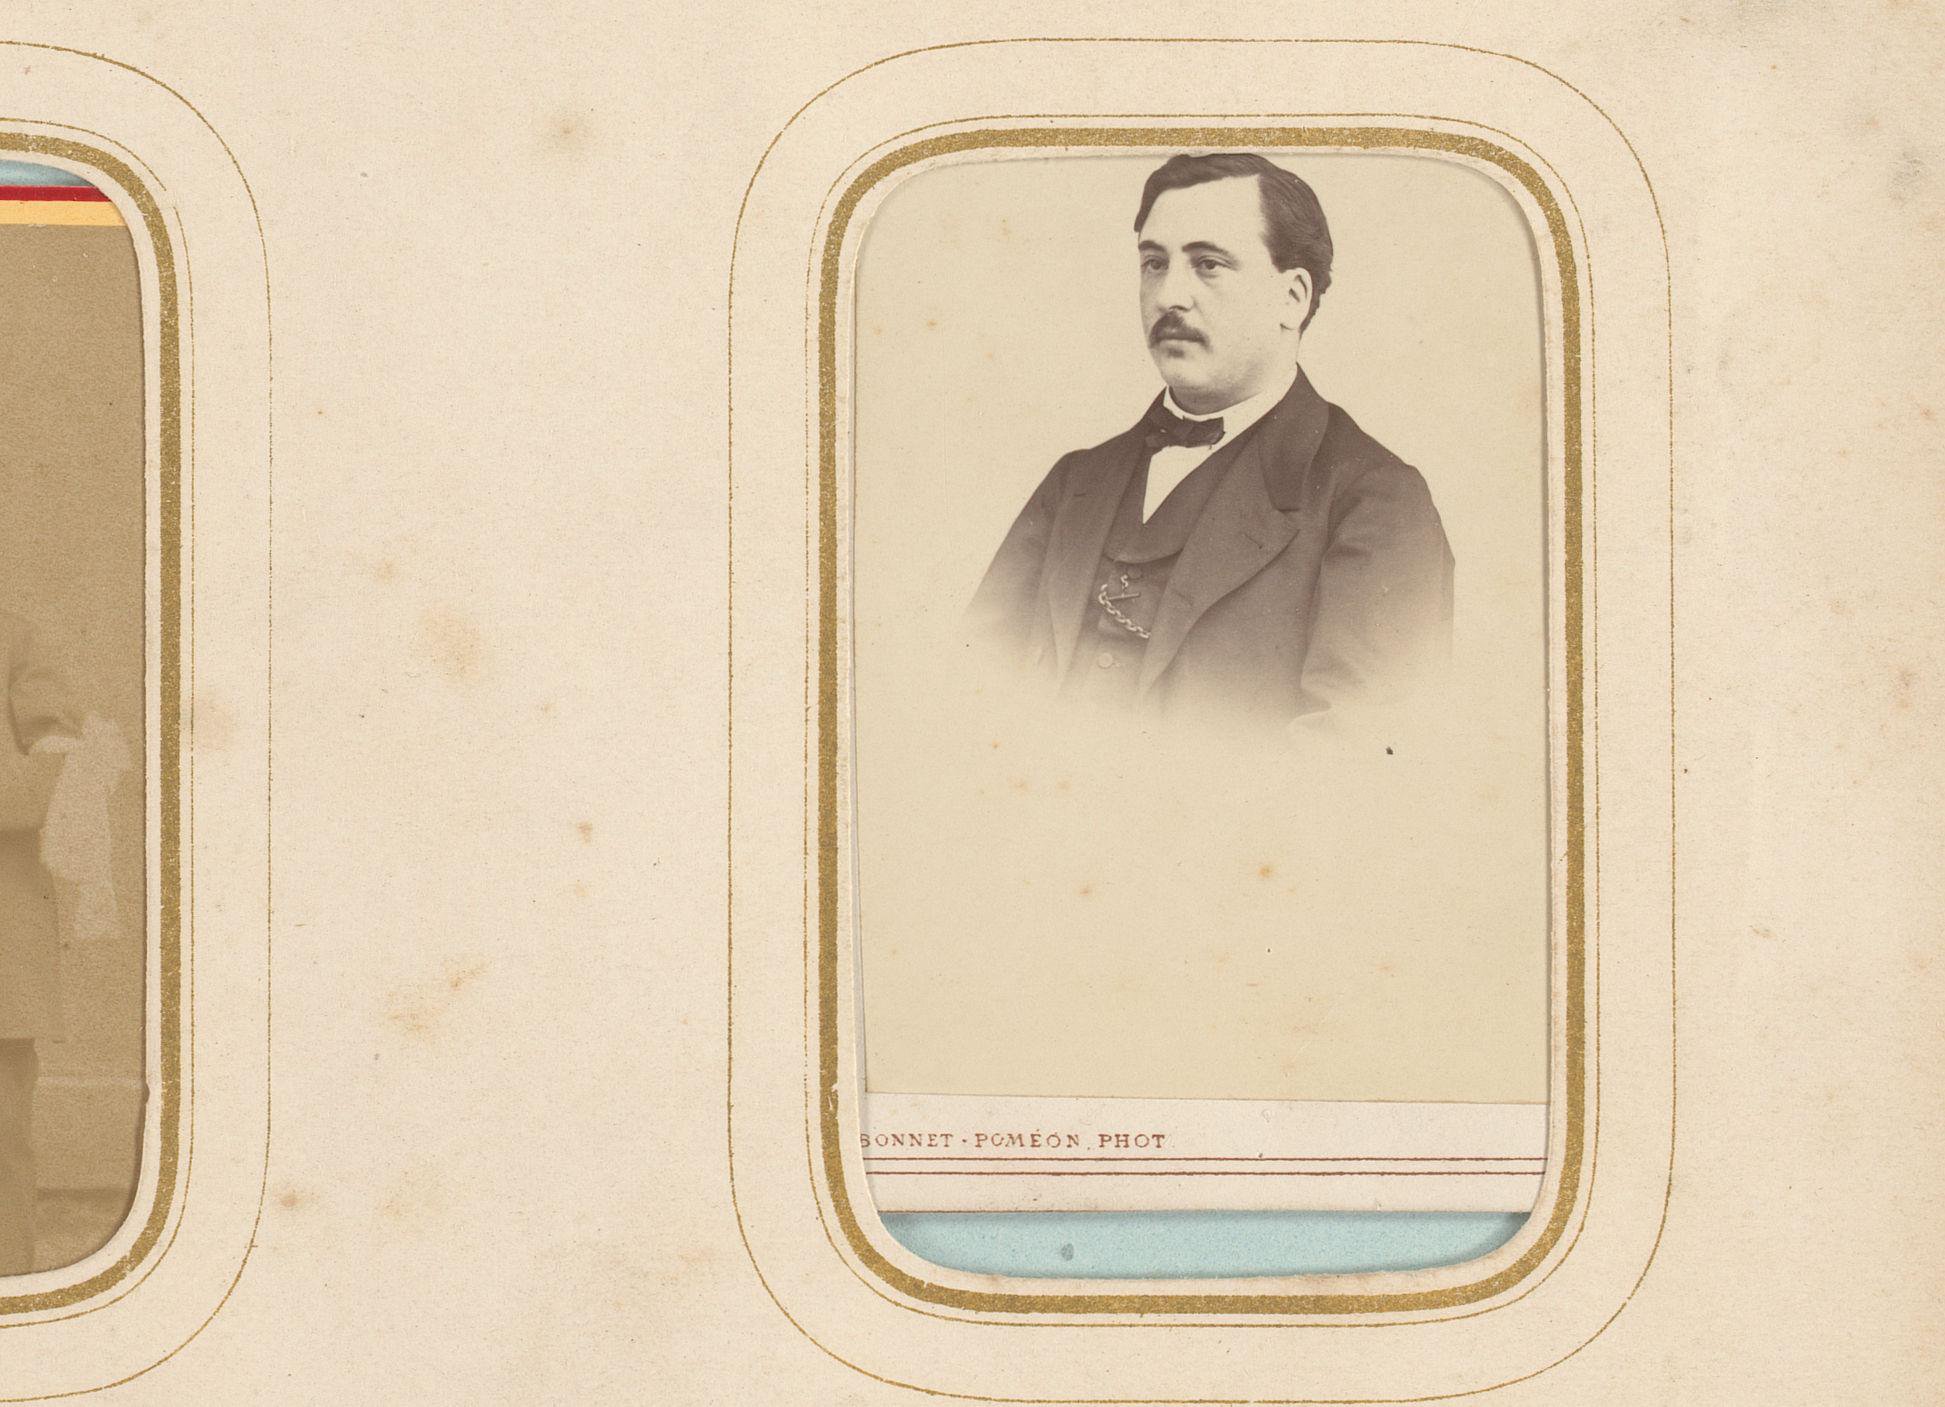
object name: carte de visite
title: Portret van een man met snor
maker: benoît bonnet-poméon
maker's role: printer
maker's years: 1827-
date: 1860-1890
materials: cardboard, photographic support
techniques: albumen print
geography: rive-de-gier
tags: moustache, historical persons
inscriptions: inscription: ‘Photographie Artistique/ Bonnet-Poméon/ Rue de Lyon 15/ Rive-de-Gier/ Loire’